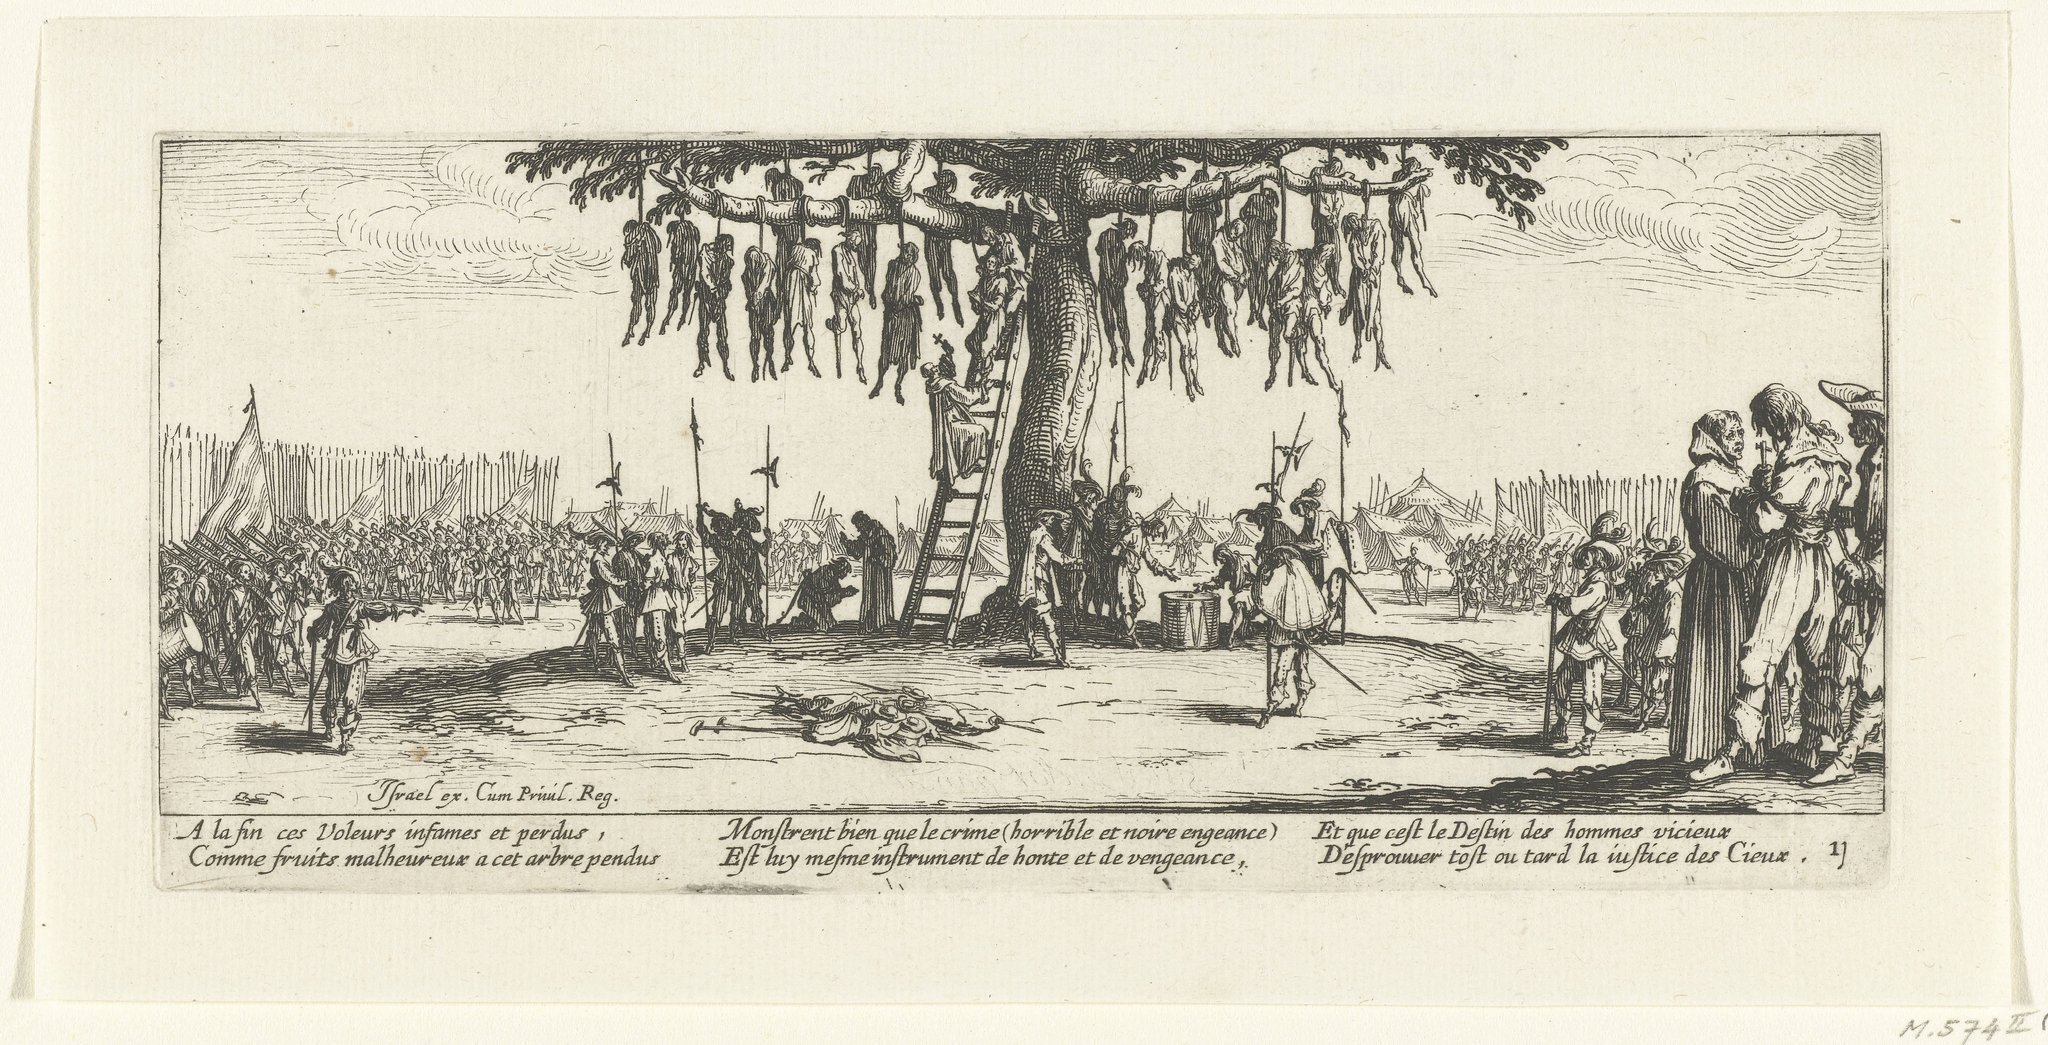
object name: print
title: De gruwelen van de oorlog (groot)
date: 1633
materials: paper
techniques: etching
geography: paris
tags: (military) camp with tents, violent death by hanging, execution ~ military disciplinary punishment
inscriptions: collector's mark: Lugt 240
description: Op een open plek in een legerkamp zijn vele soldaten verzameld rond een grote boom waaraan 21 lijken hangen en nog meer executies door ophanging plaats zullen vinden. Eén veroordeelde wordt juist de strop omgebonden, enkele anderen wachten onder de boom op hun beurt. Rechts op de voorgrond is een veroordeelde in gesprek met een geestelijke. Onder de voorstelling een zesregelig Frans vers. Deze prent is onderdeel van een serie van 17 (18 incl. titelprent) prenten met voorstellingen van diverse soorten ellende die oorlogvoering met zich meebrengt.